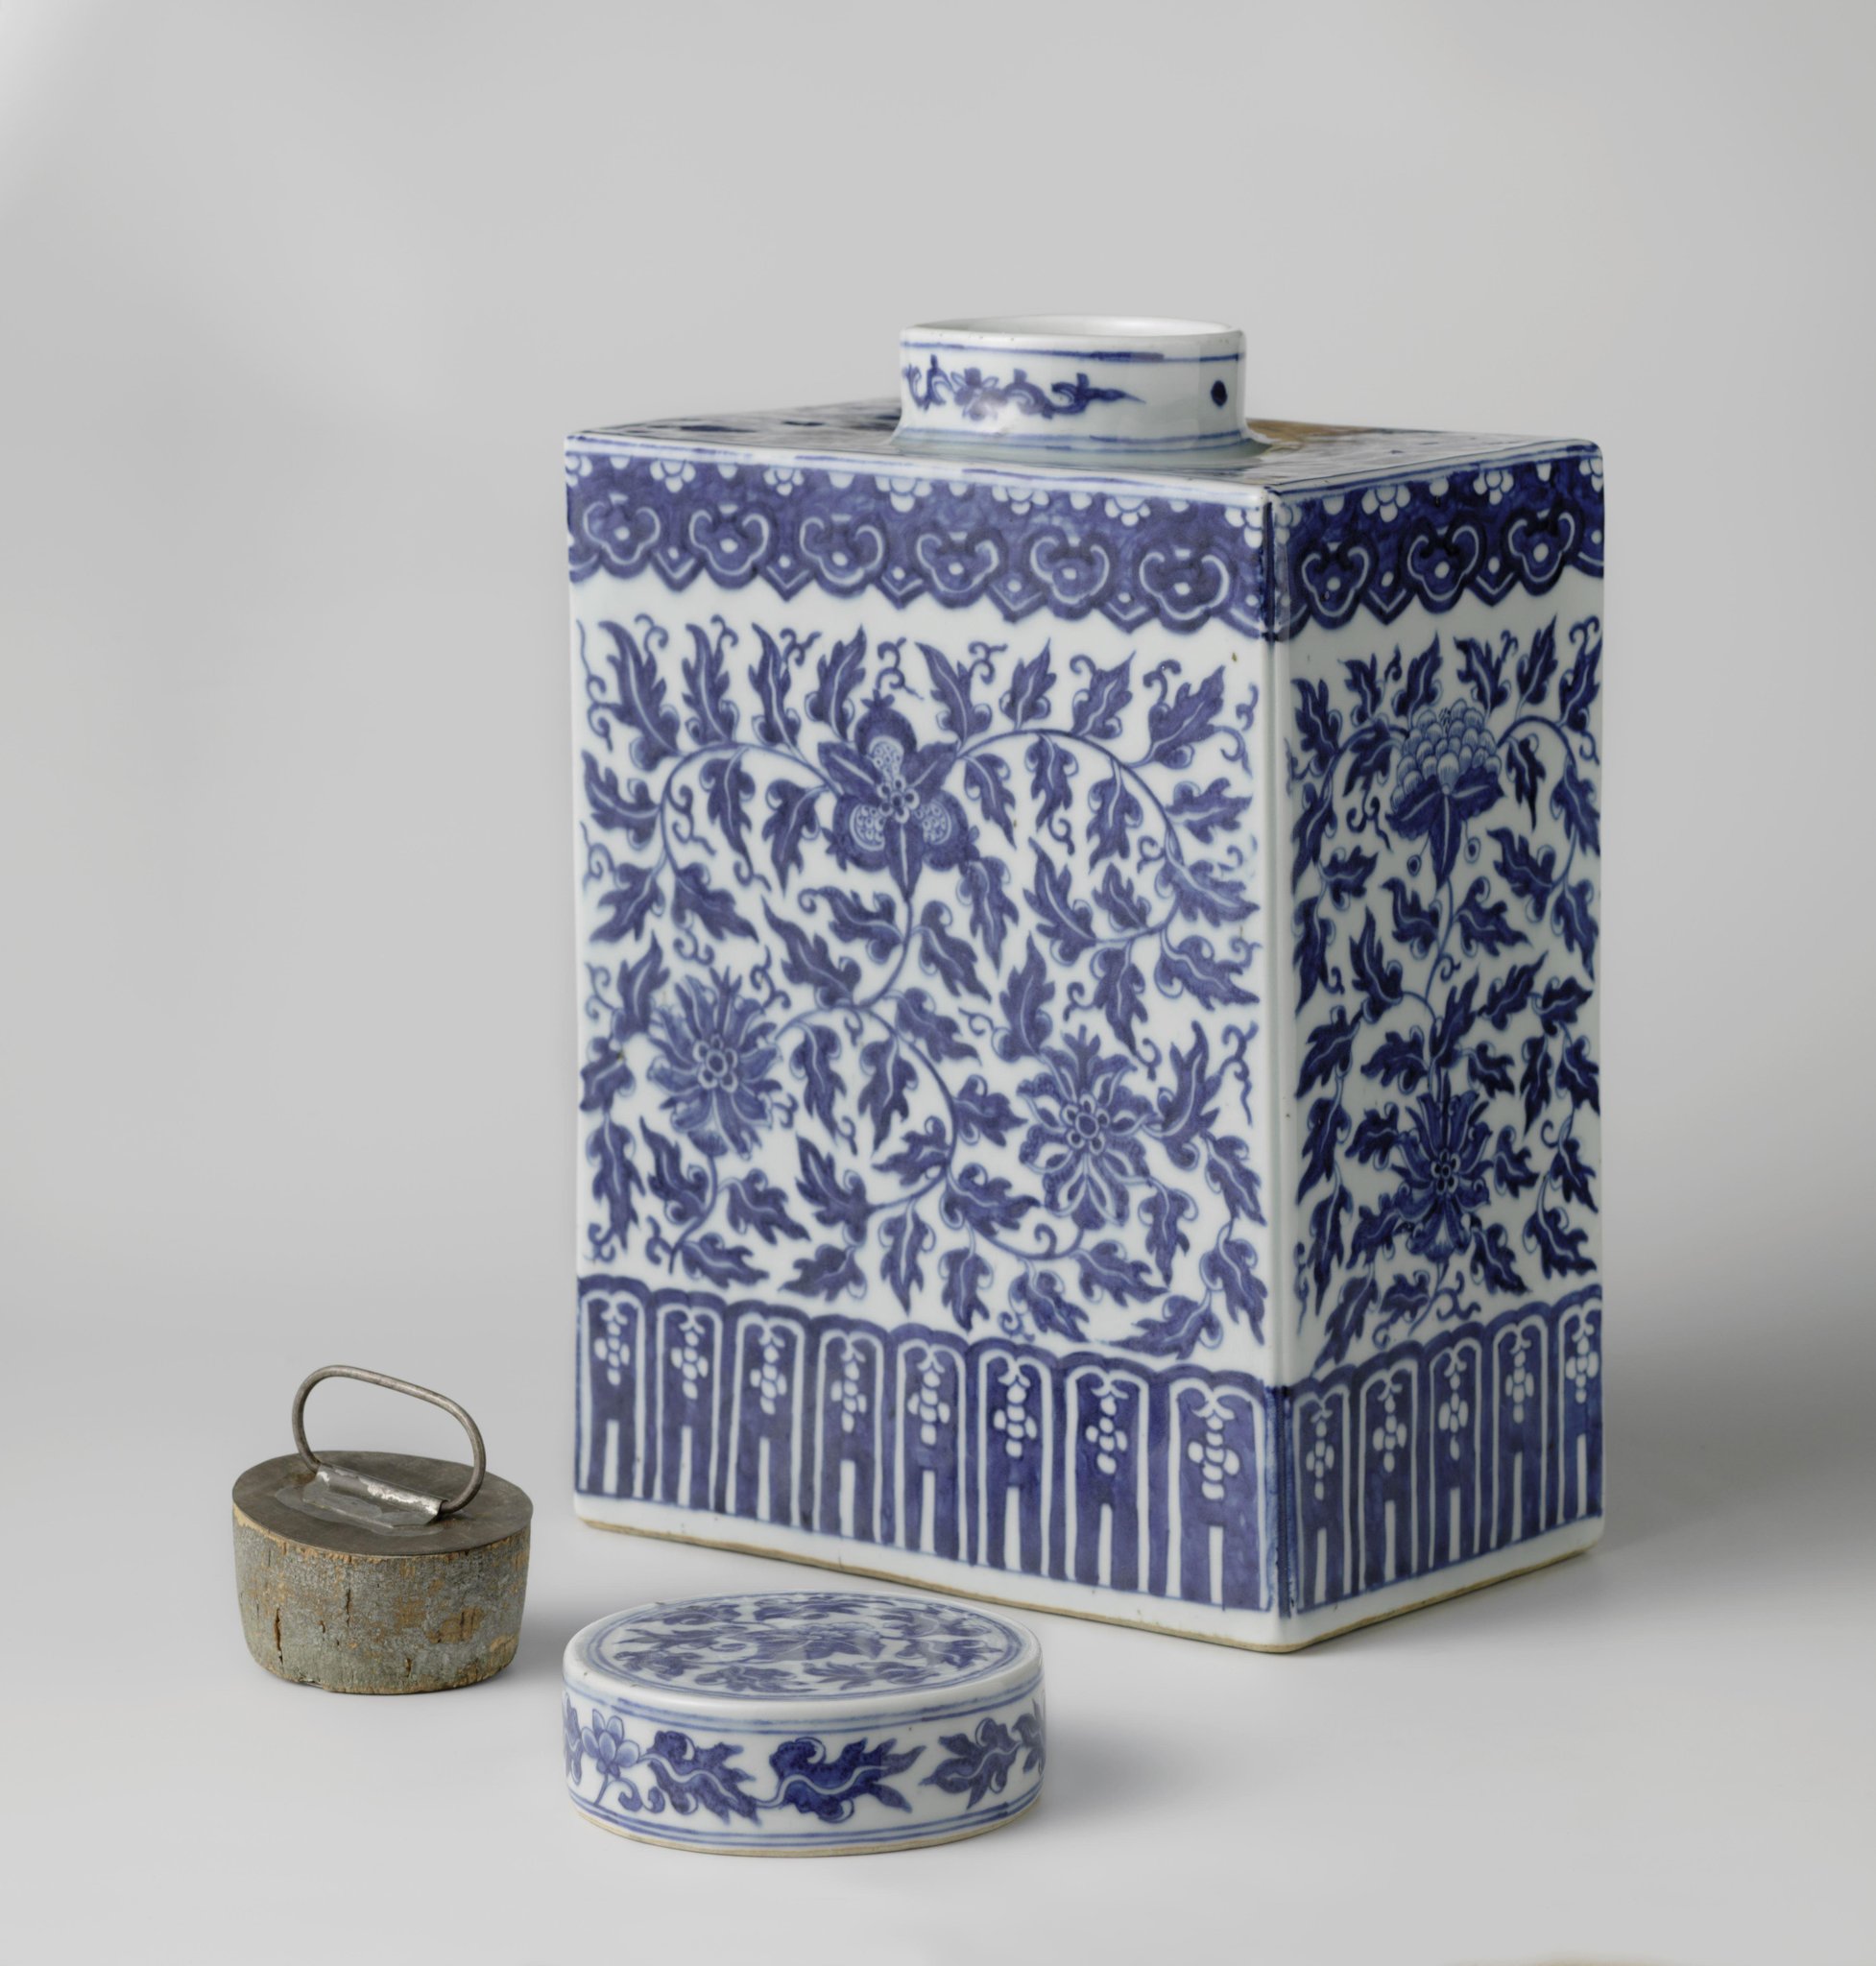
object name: tea caddy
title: Rectangular tea caddy with flower scrolls and bats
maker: Anonymous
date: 1875-1899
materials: cork, iron, paint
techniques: firing, turning, vitrification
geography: china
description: Theebus, met deksel, met gestileerde bloem- en bladranken naar Perzisch voorbeeld.